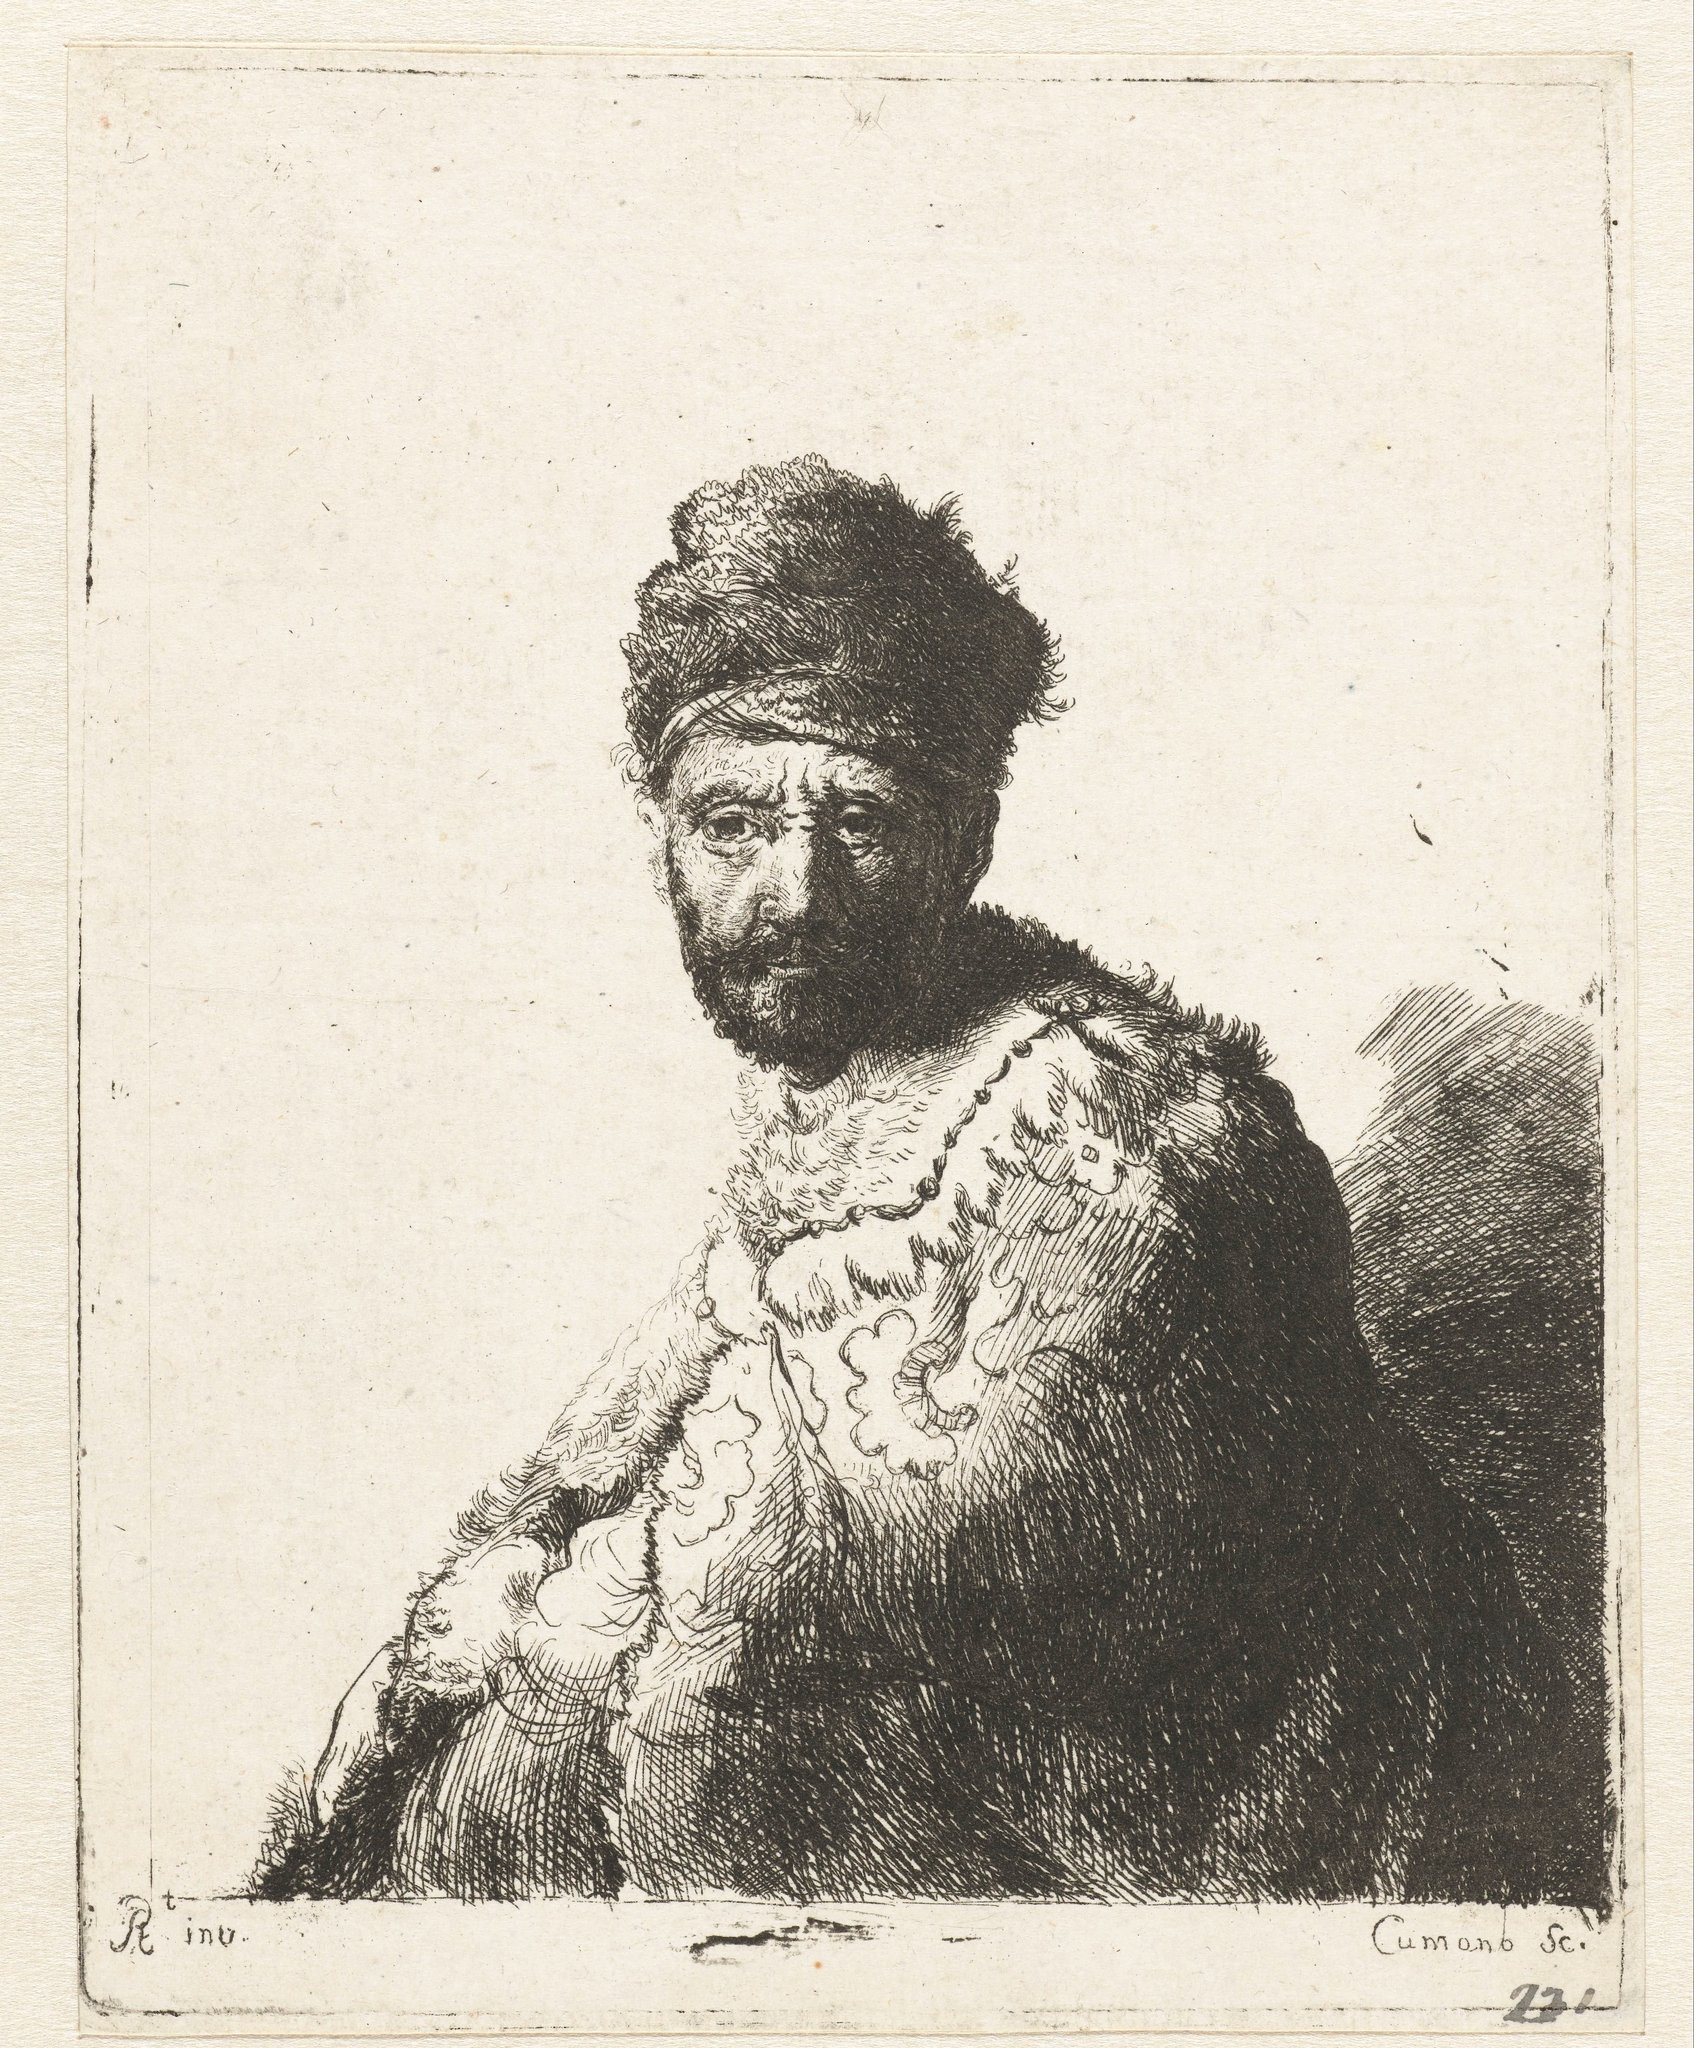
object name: print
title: Bearded man, in a furred oriental cap and robe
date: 1770-1803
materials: paper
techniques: etching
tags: head-gear: cap (+ men's clothes), adult man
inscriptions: number: ‘231’, collector's mark: Lugt 2760, collector's mark: Lugt 2228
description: Spiegelbeeldige kopie naar de gelijknamige prent van Rembrandt.